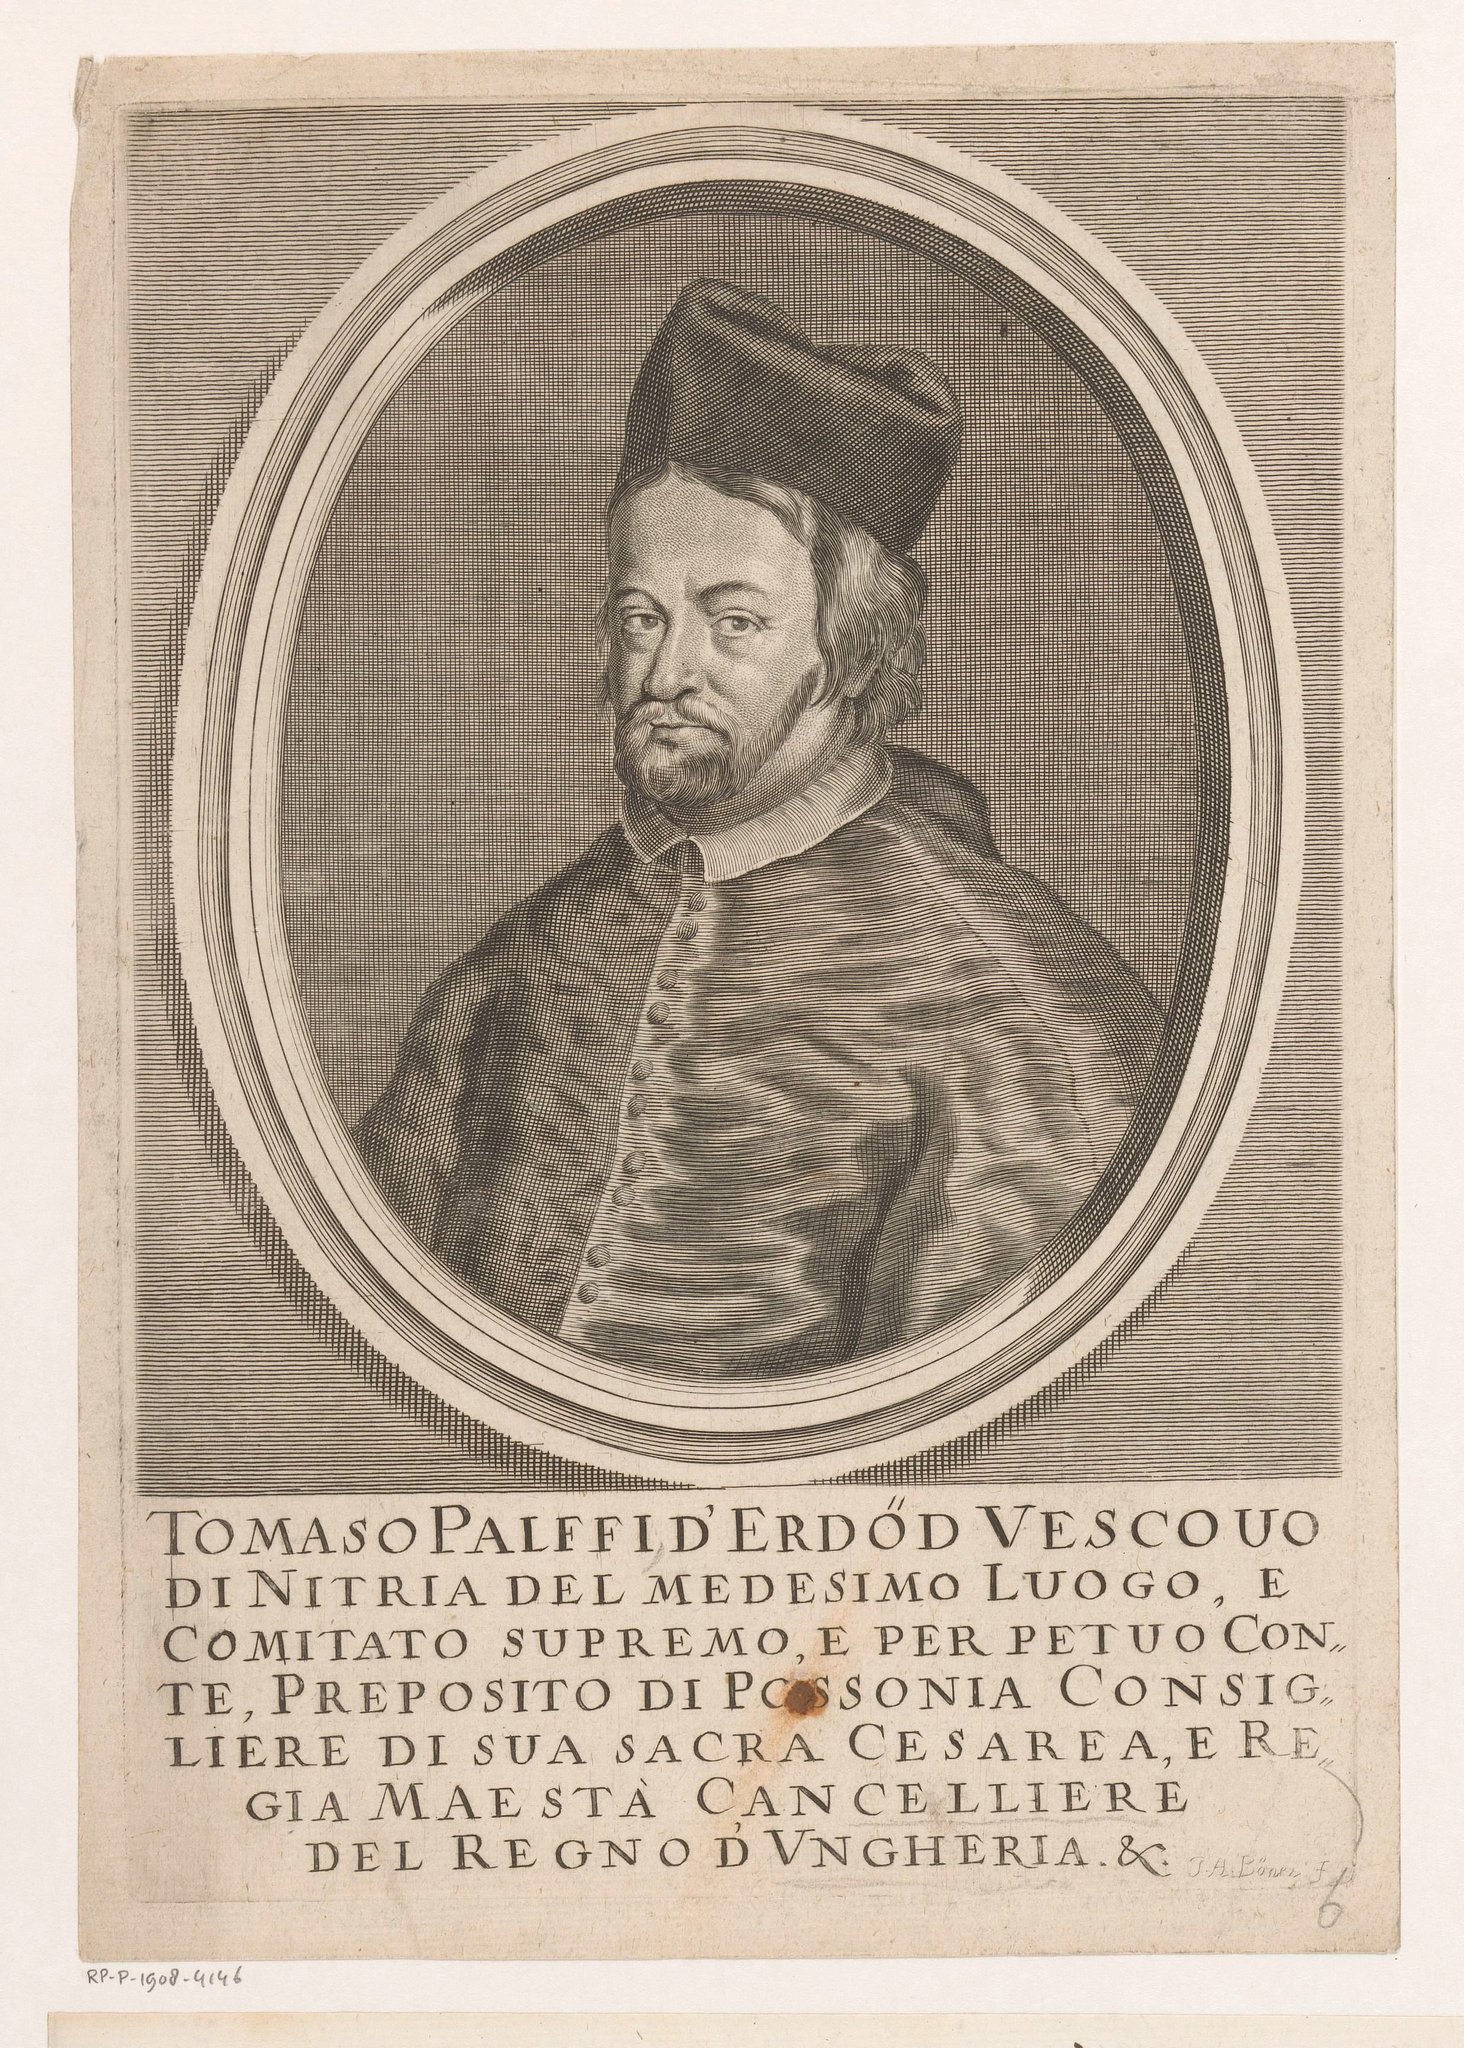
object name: print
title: Portret van Tomáš Pálffy, bisschop van Nitra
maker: johann alexander böner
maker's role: draughtsman, print maker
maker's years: 1647-1720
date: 1674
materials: paper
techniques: engraving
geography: nuremberg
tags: historical persons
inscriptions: collector's mark: Lugt 2228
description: Prent ook gebruikt in: Gualdo Priorato, Galeazzo. Historia di Leopoldo Cesare. 3 dln. Wenen: Johann Baptist Hacque, 1670-1674, dl. 3 [1674], na p. 720.